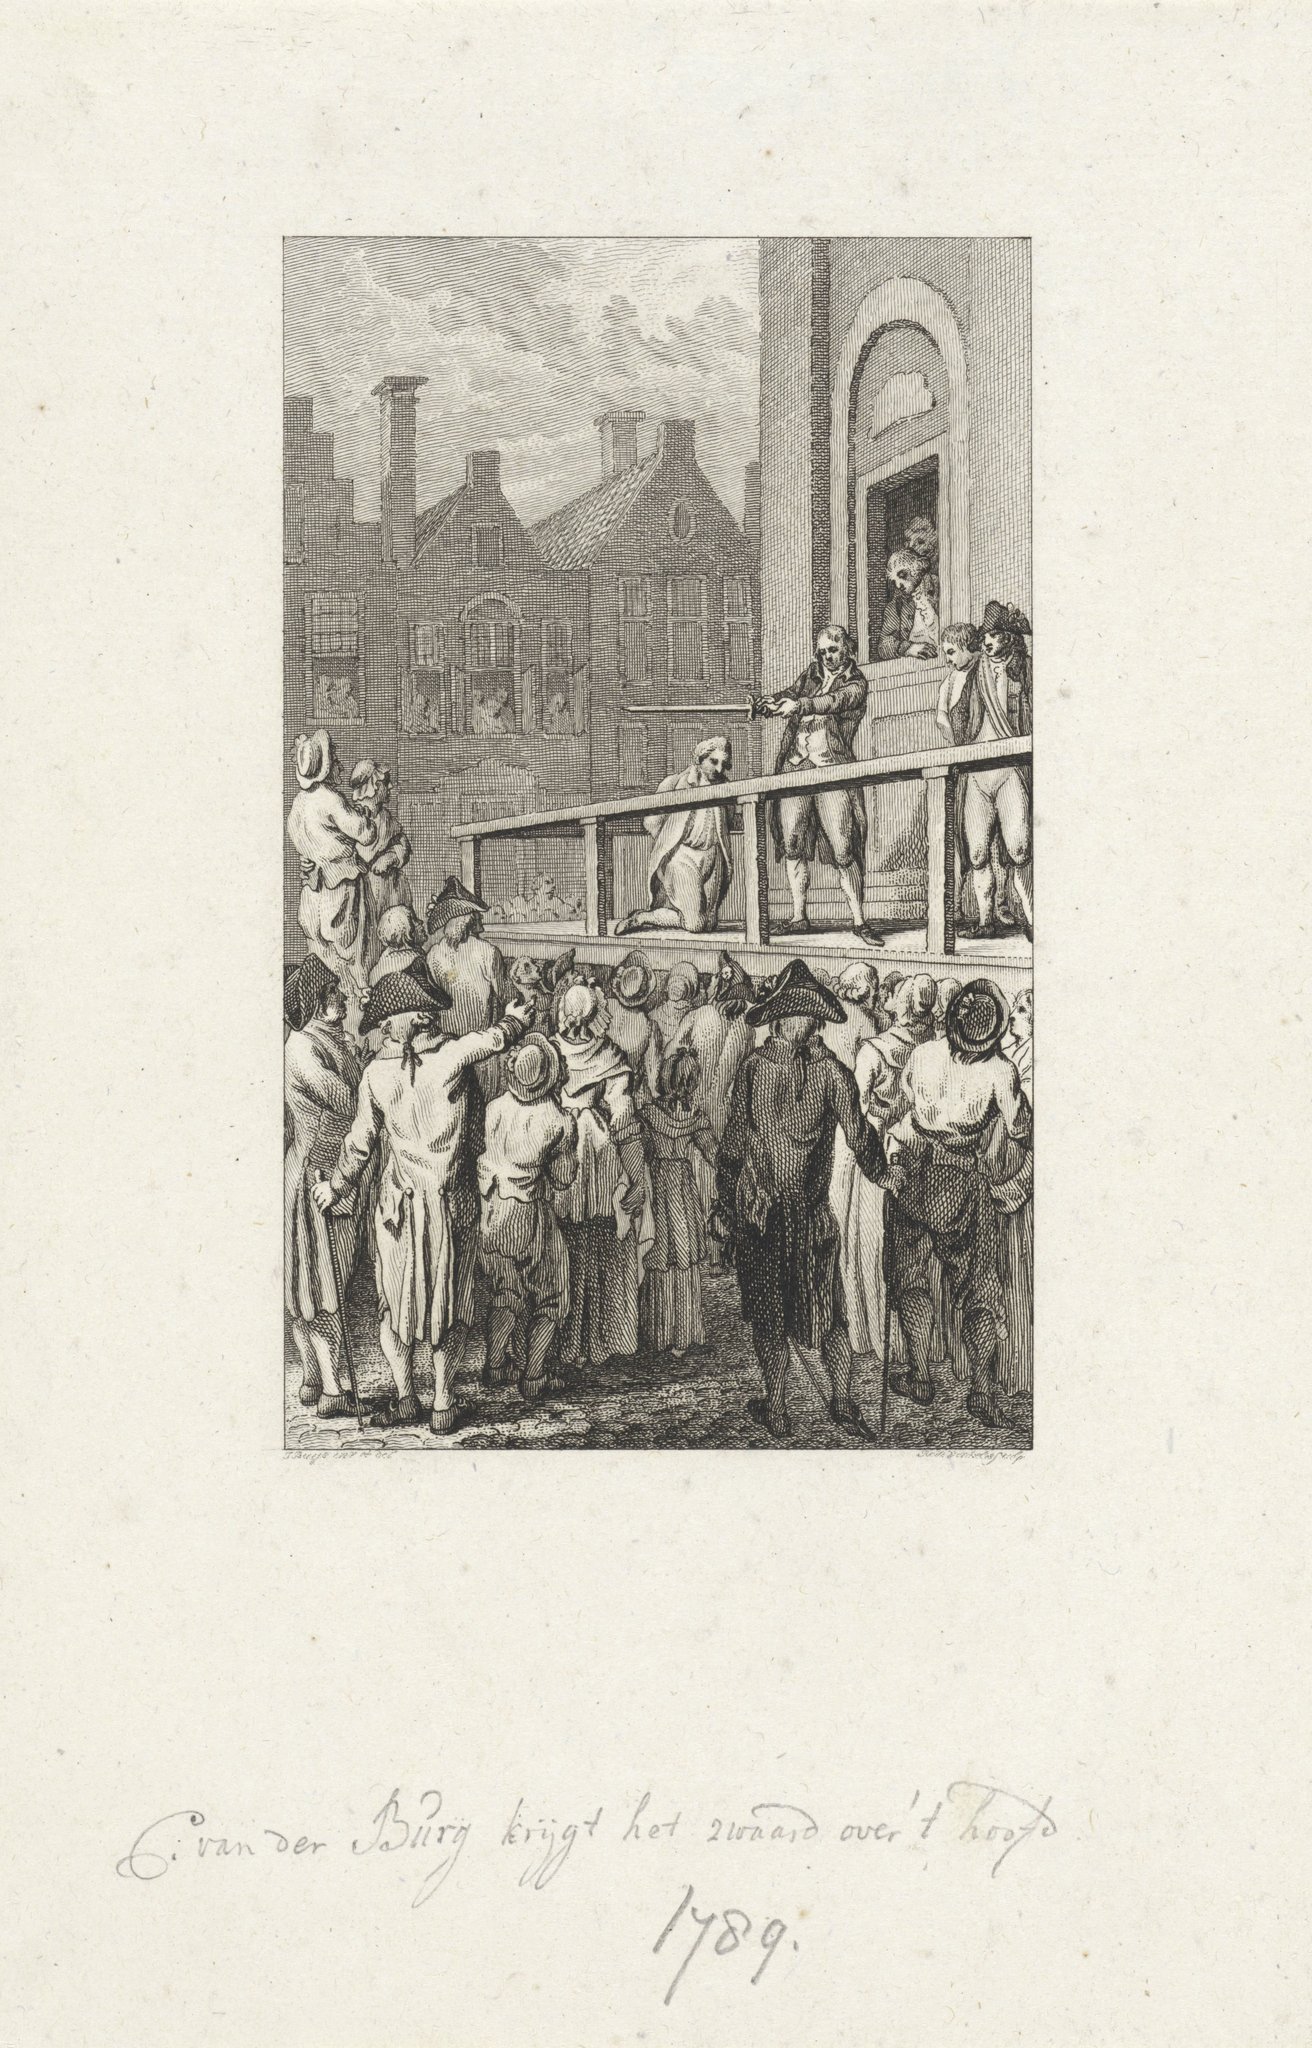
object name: print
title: Terechtstelling van burgemeester Cornelis van der Burgh te Leeuwarden, 1789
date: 1799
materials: paper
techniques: engraving, etching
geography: amsterdam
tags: mayor, pardon, reprieve, violent death by hanging, patriots (1780-1795)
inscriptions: collector's mark: Lugt 240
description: Terechtstelling van Cornelis van der Burg, uitgesproken patriotse burgemeester van Bolsward, te Leeuwarden op 16 mei 1789. Als de burgemeester knielt op het schavot houdt de beul het zwaard boven zijn hoofd en wordt het doodsvonnis omgezet in een verbanning van twintig jaar.